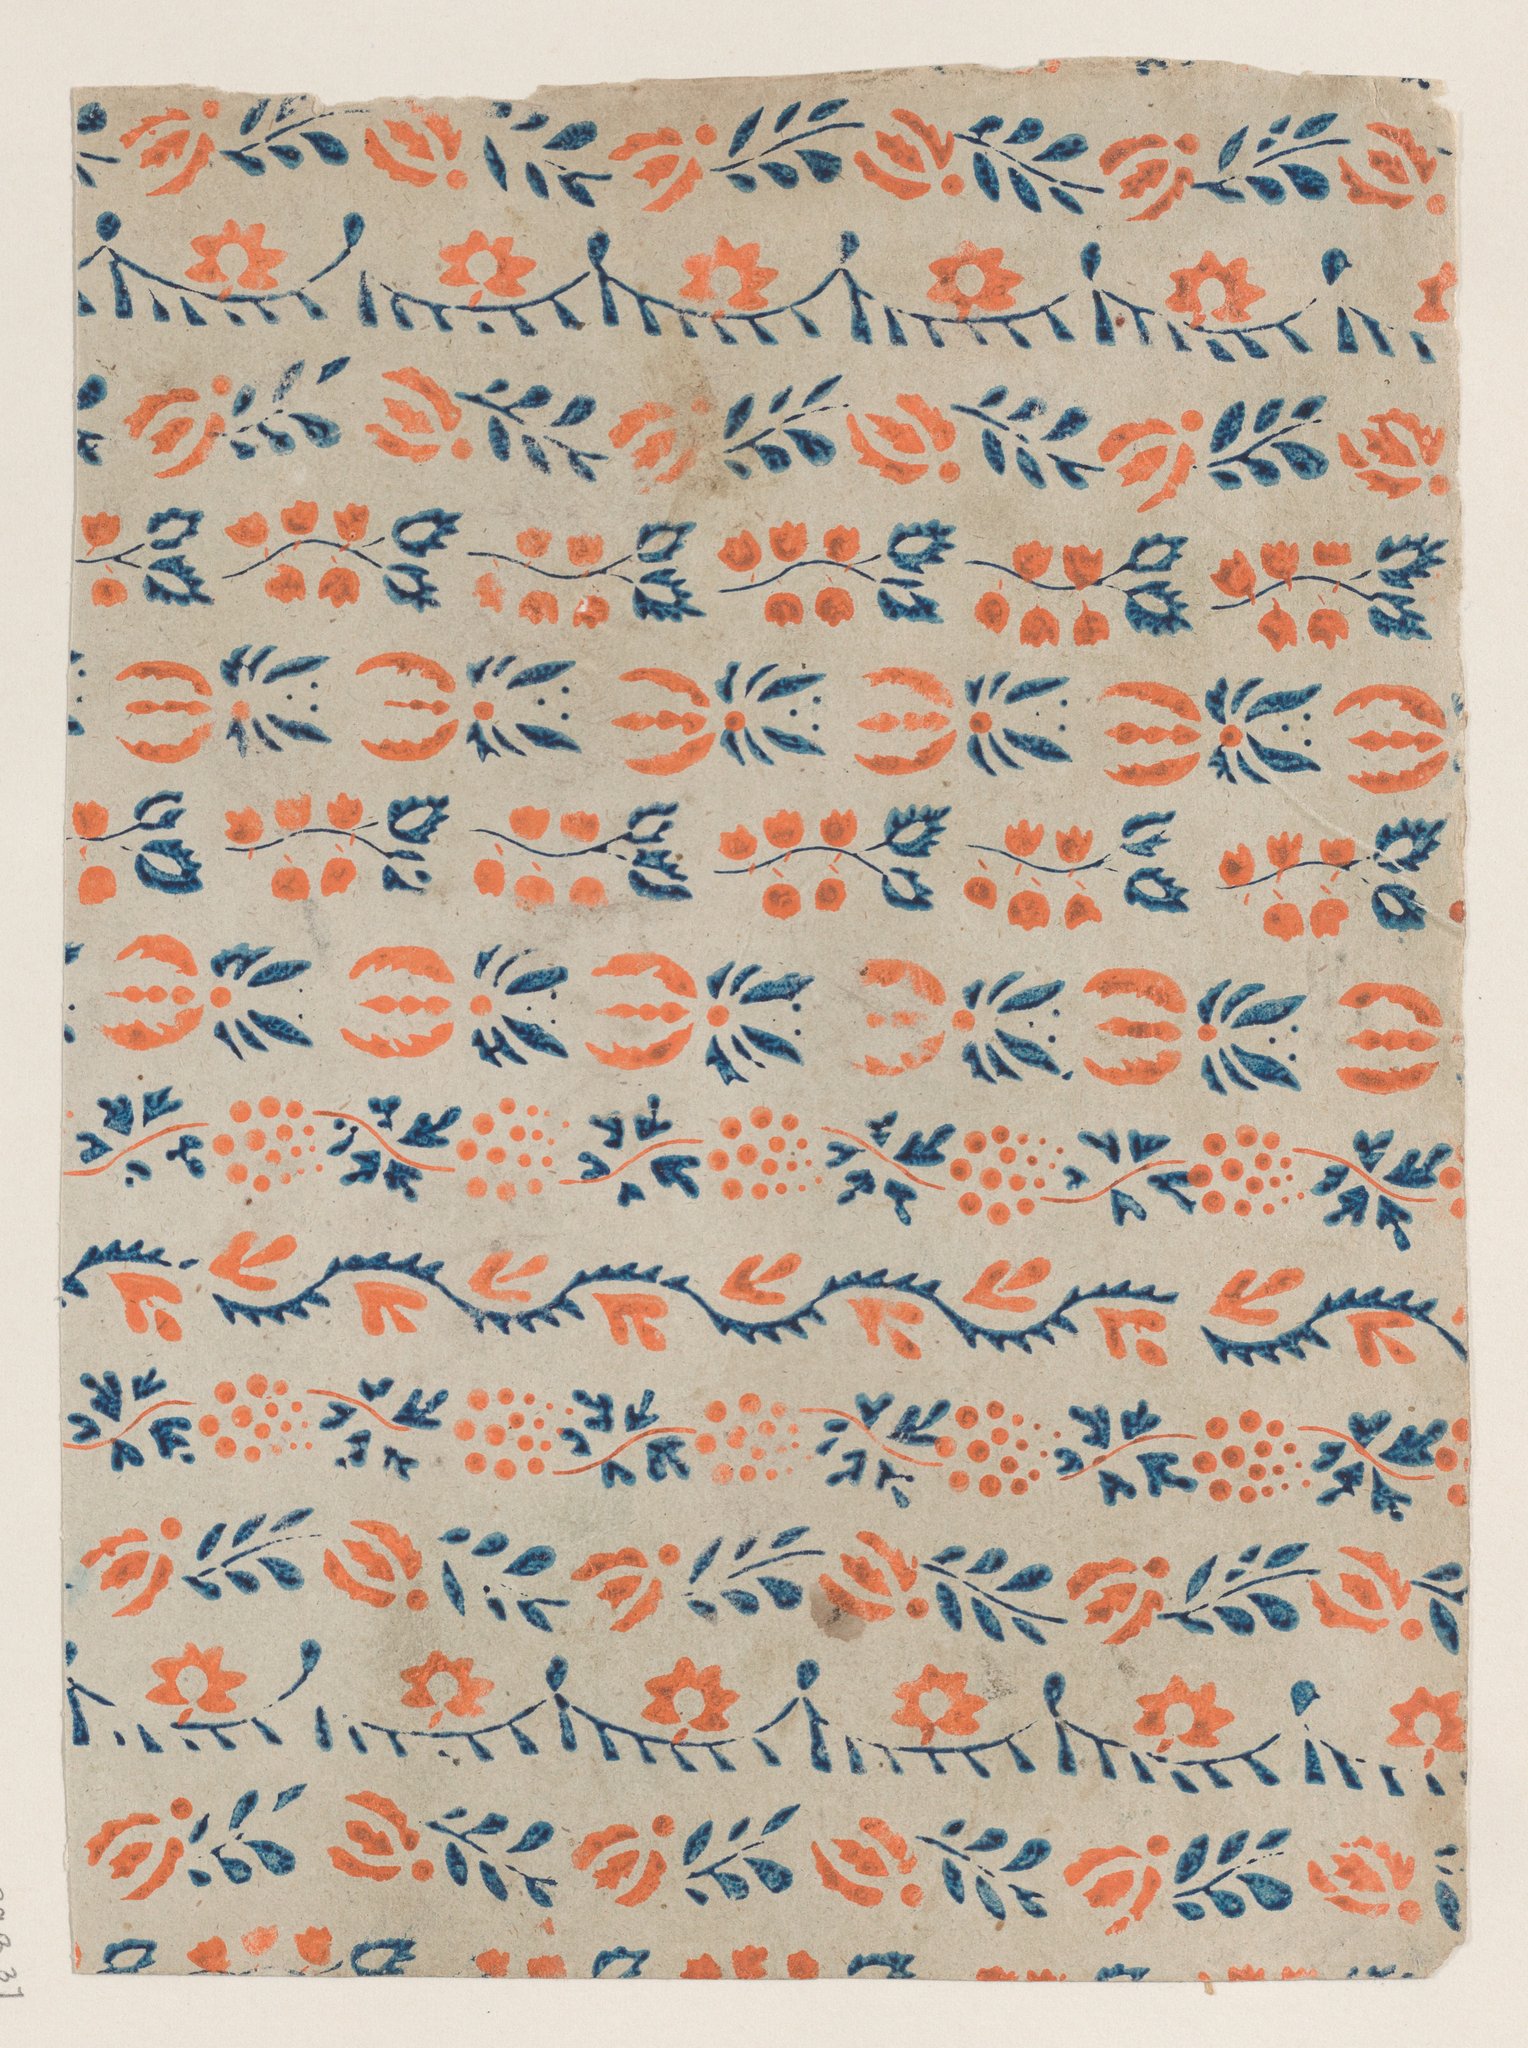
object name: print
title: Sheet with blue and orange floral pattern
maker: Anonymous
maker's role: artist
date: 1801-1900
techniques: relief print